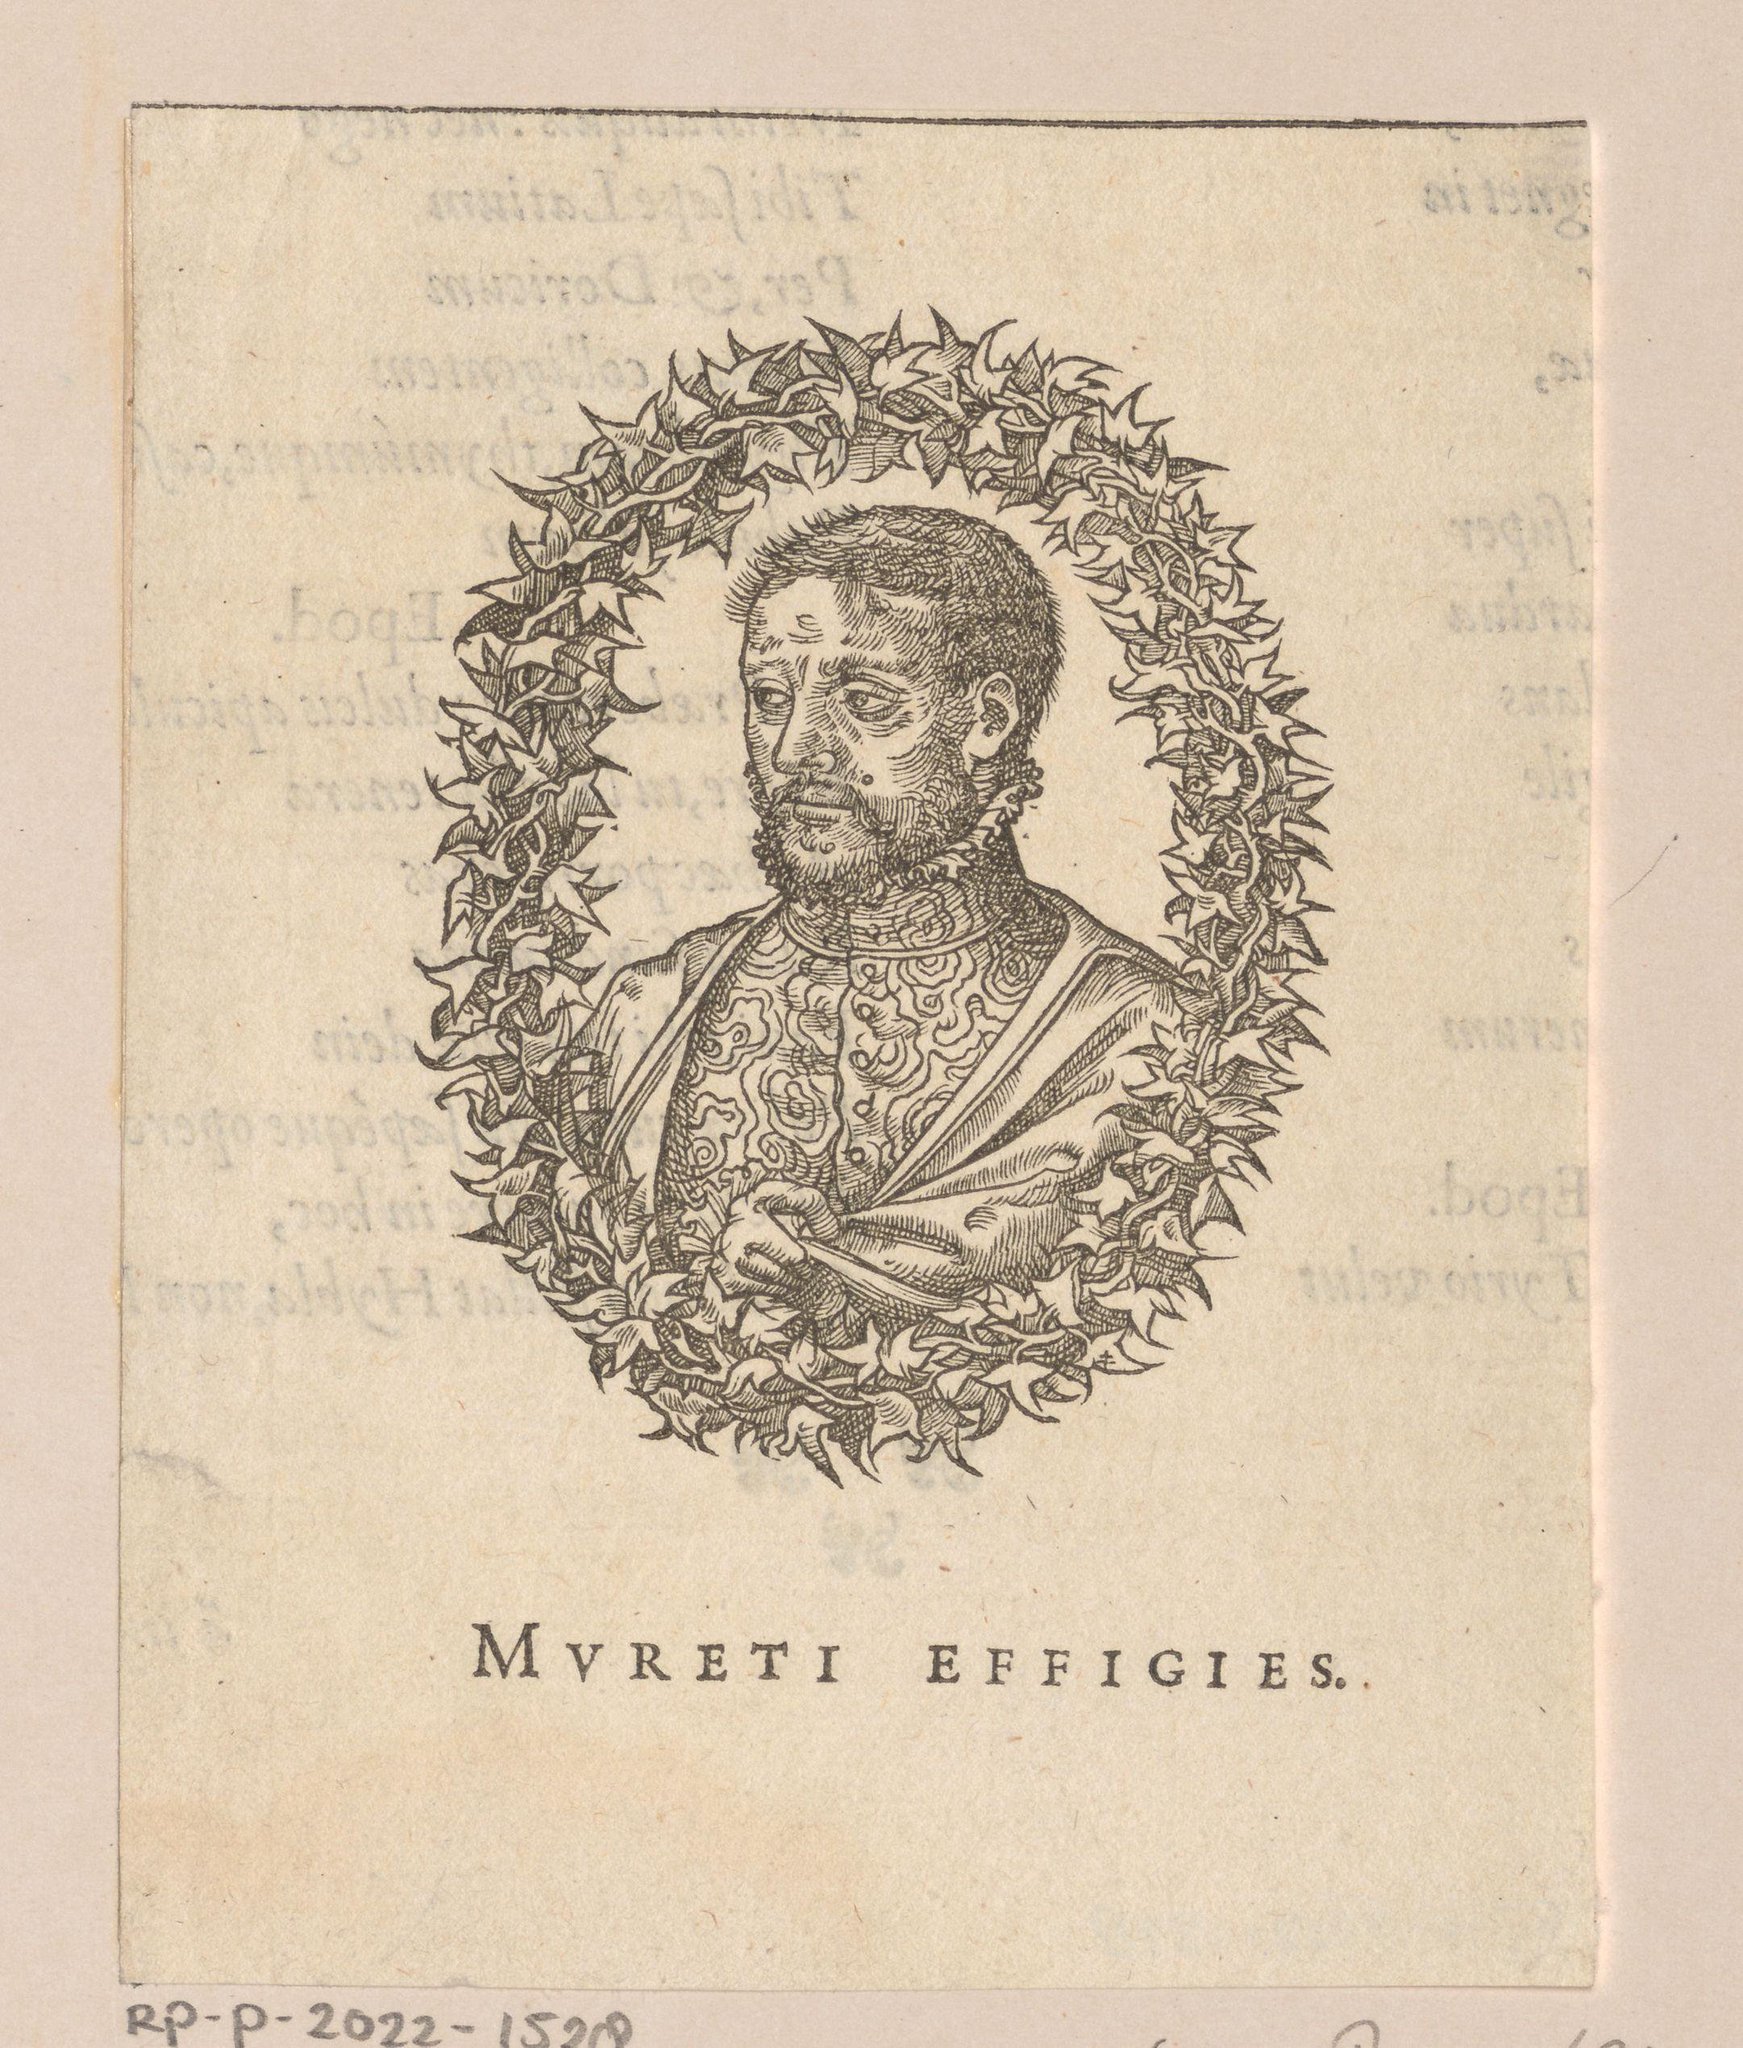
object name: print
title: Portret van Marco Antonio Muretus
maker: Anonymous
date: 1609-1700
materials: paper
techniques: letterpress printing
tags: rome, scholar, philosopher, historical persons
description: Ook gepubliceerd in: Ronsard, Pierre de. Les oeuures de Pierre de Ronsard gentilhomme (...). Parijs: s.n., 1609-1623.